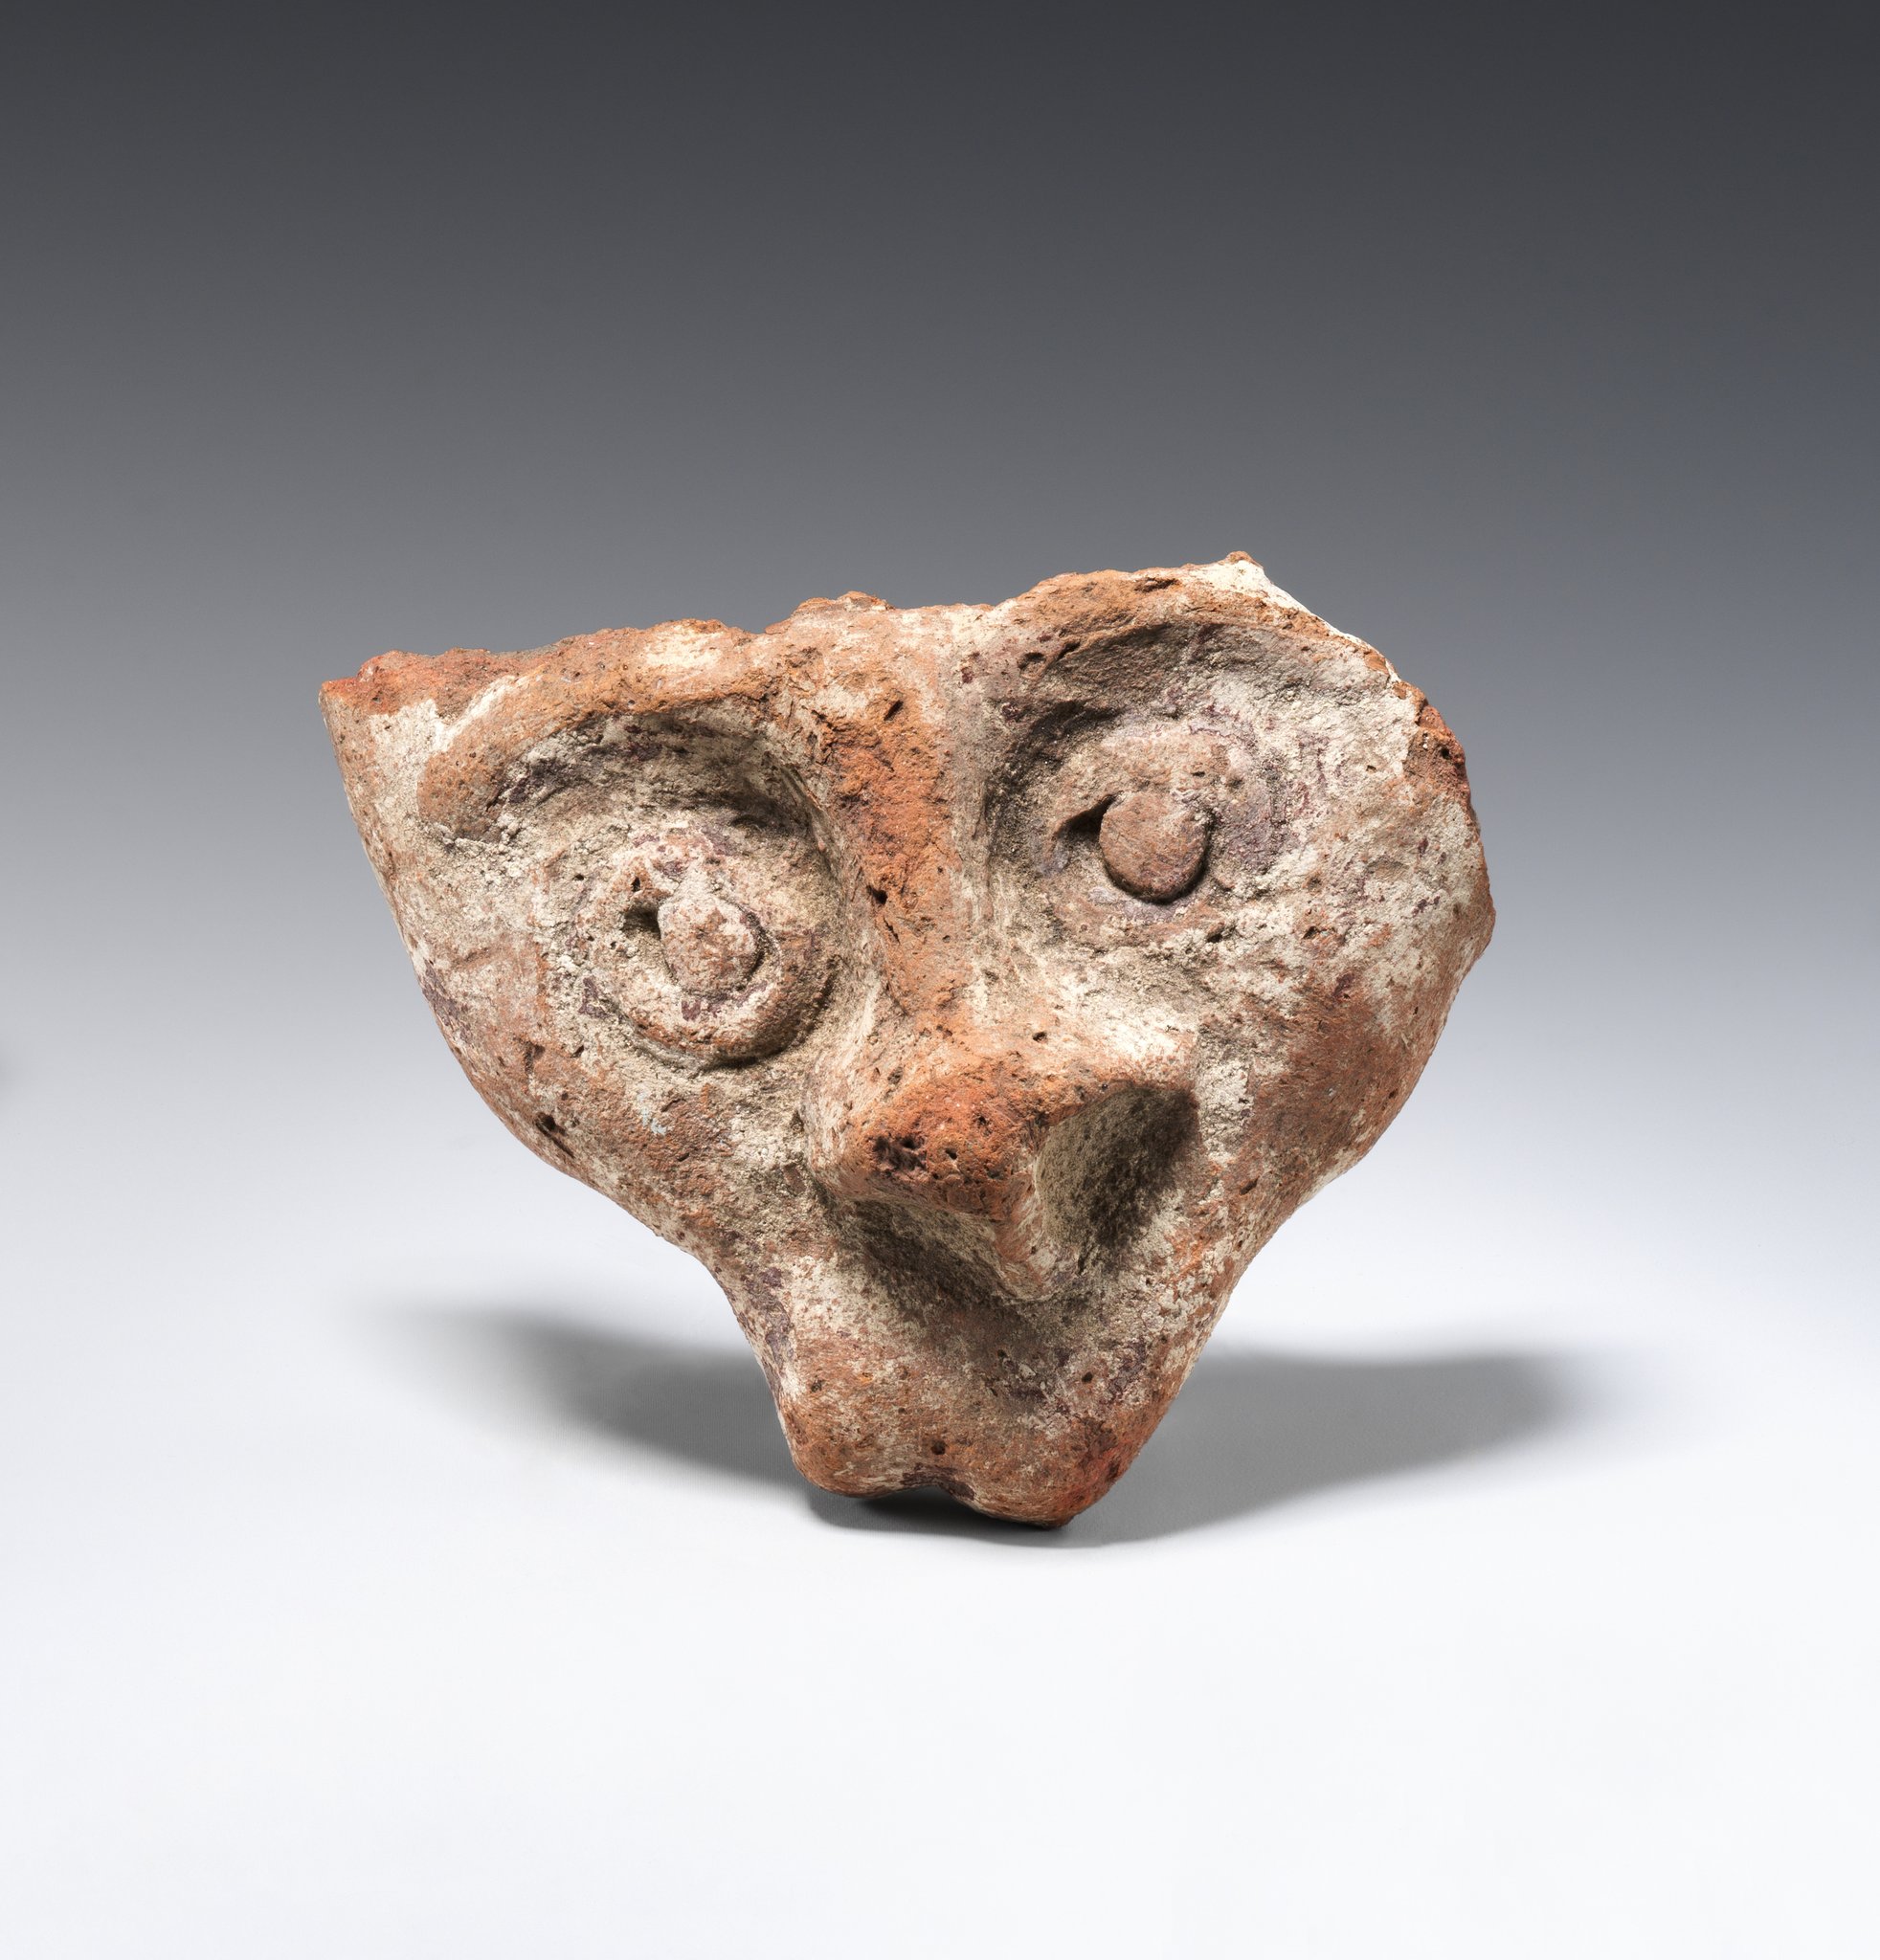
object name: figurine fragment, male head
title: Face from human figure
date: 306-30 BCE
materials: paint, pottery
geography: egypt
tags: heads